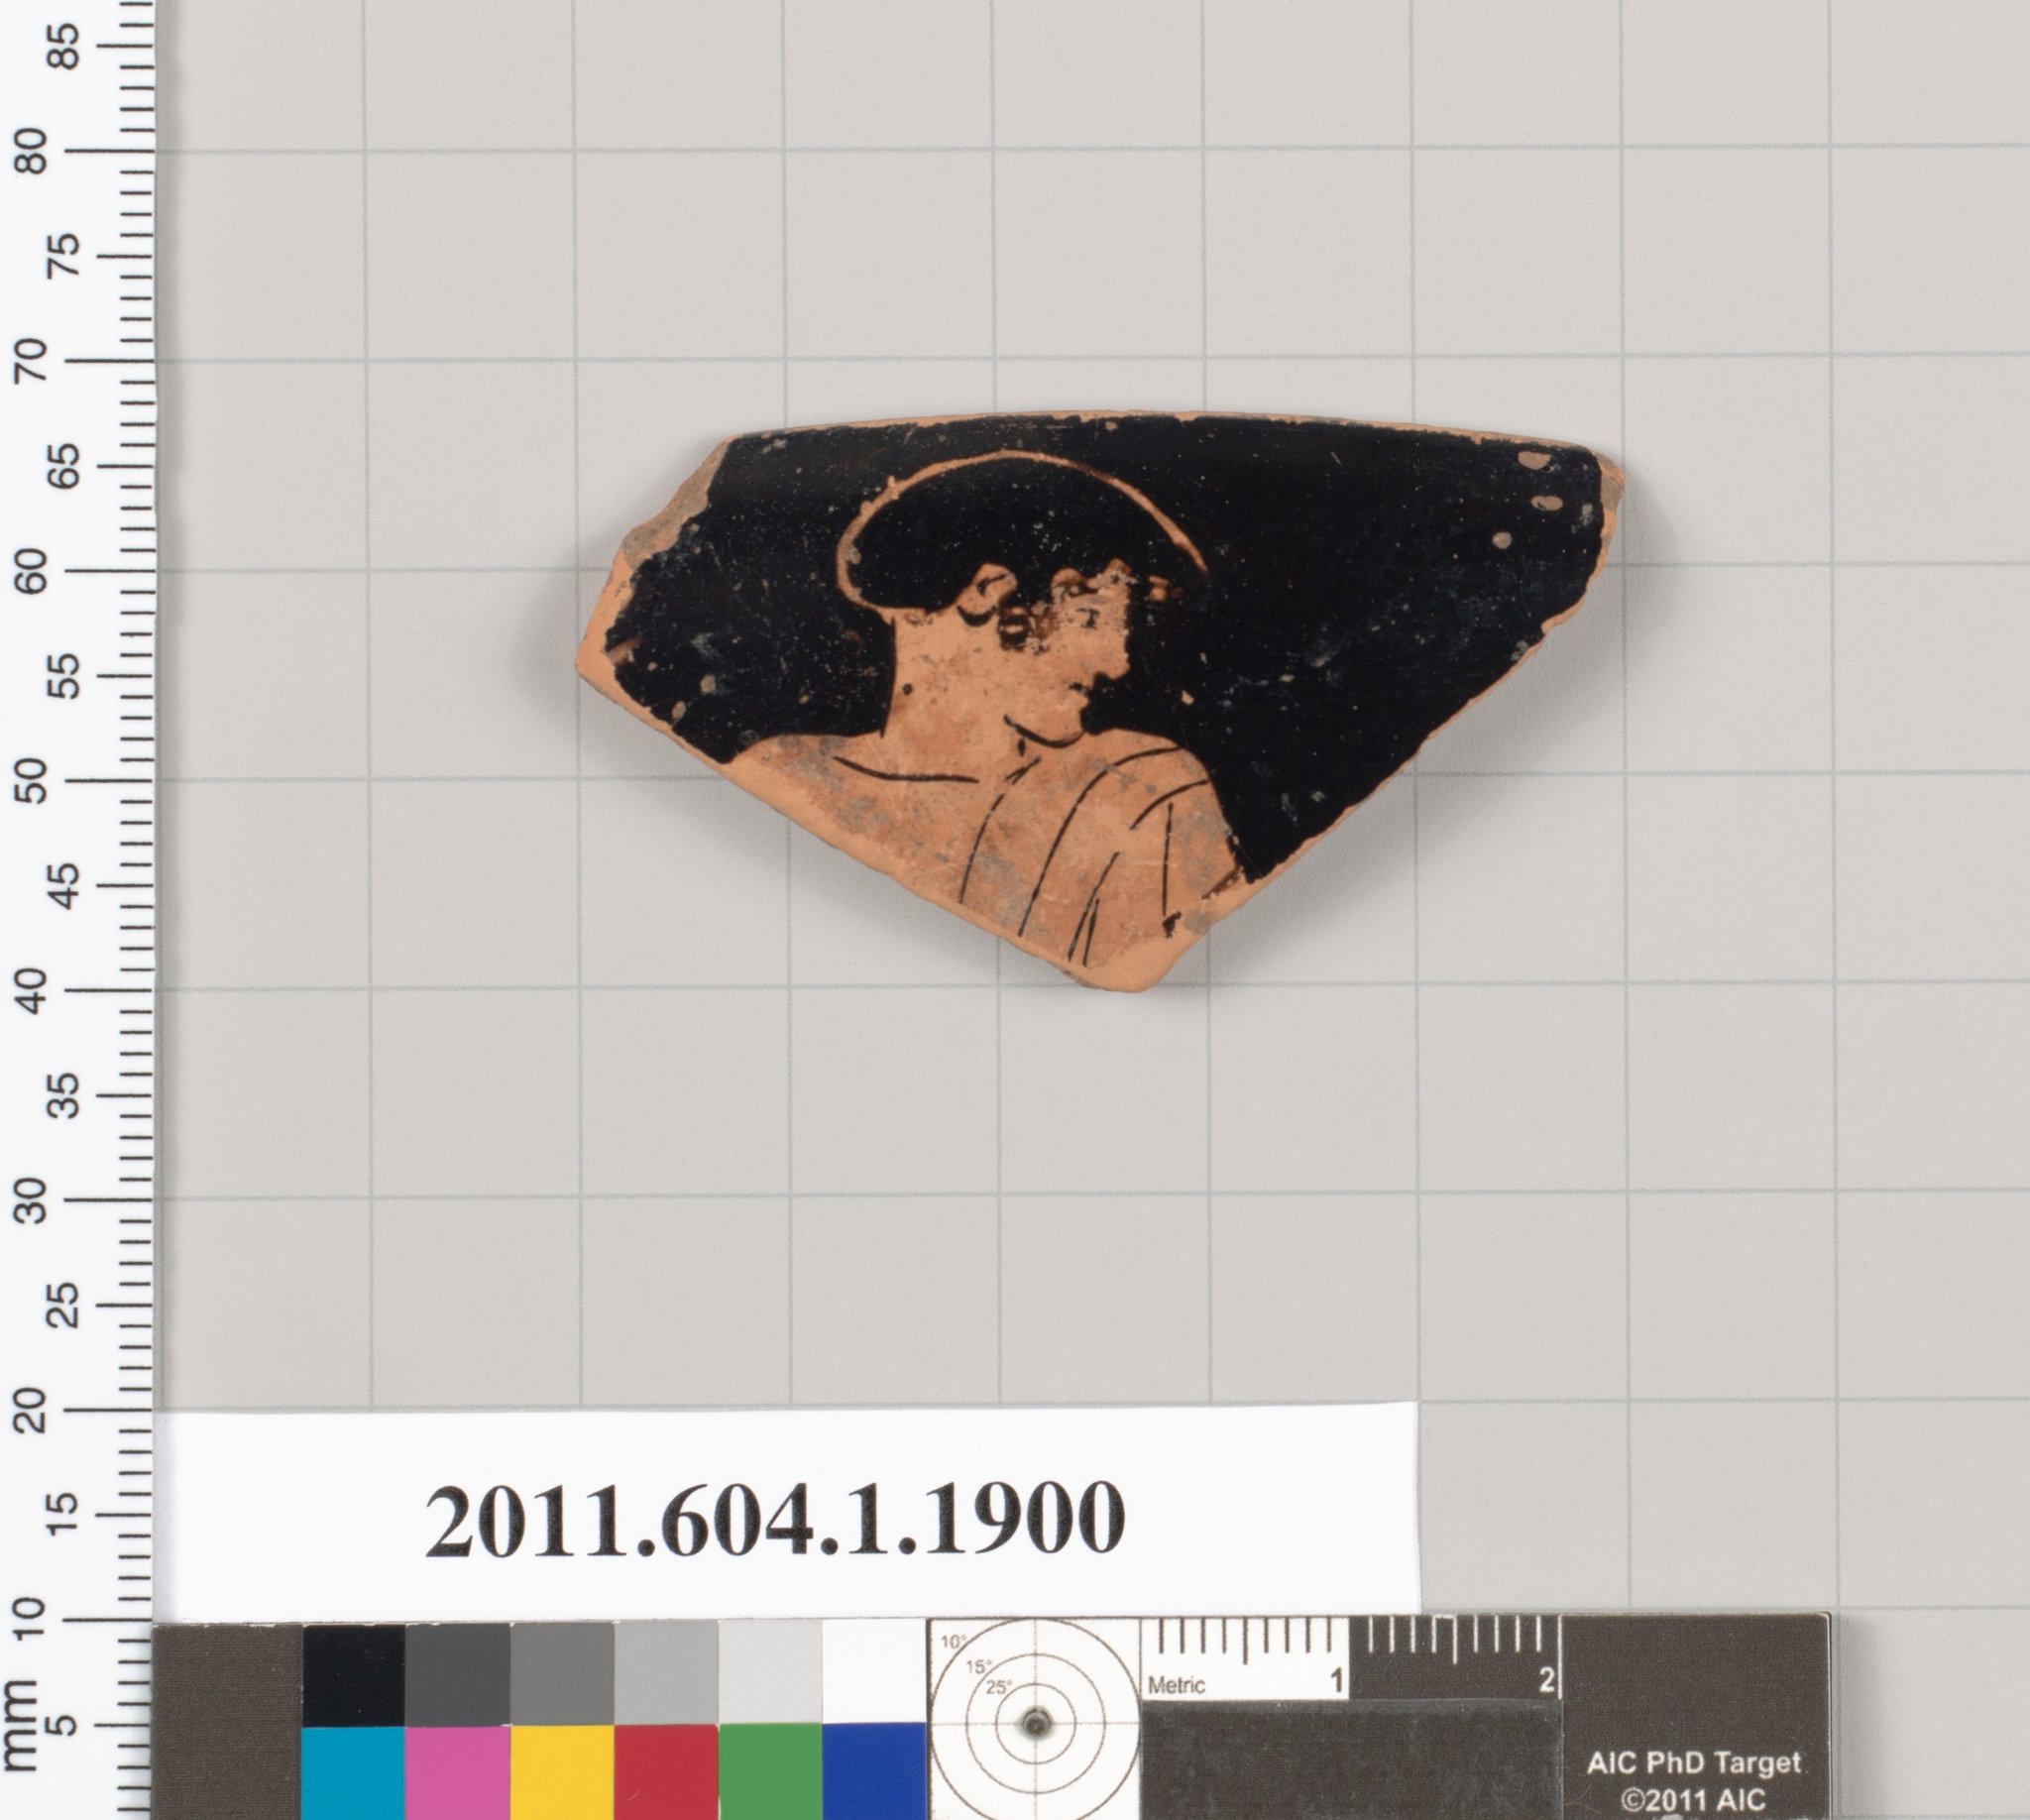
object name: kylix fragment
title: Terracotta rim fragment of a kylix (drinking cup)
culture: greek, attic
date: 475-451 BCE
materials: terracotta